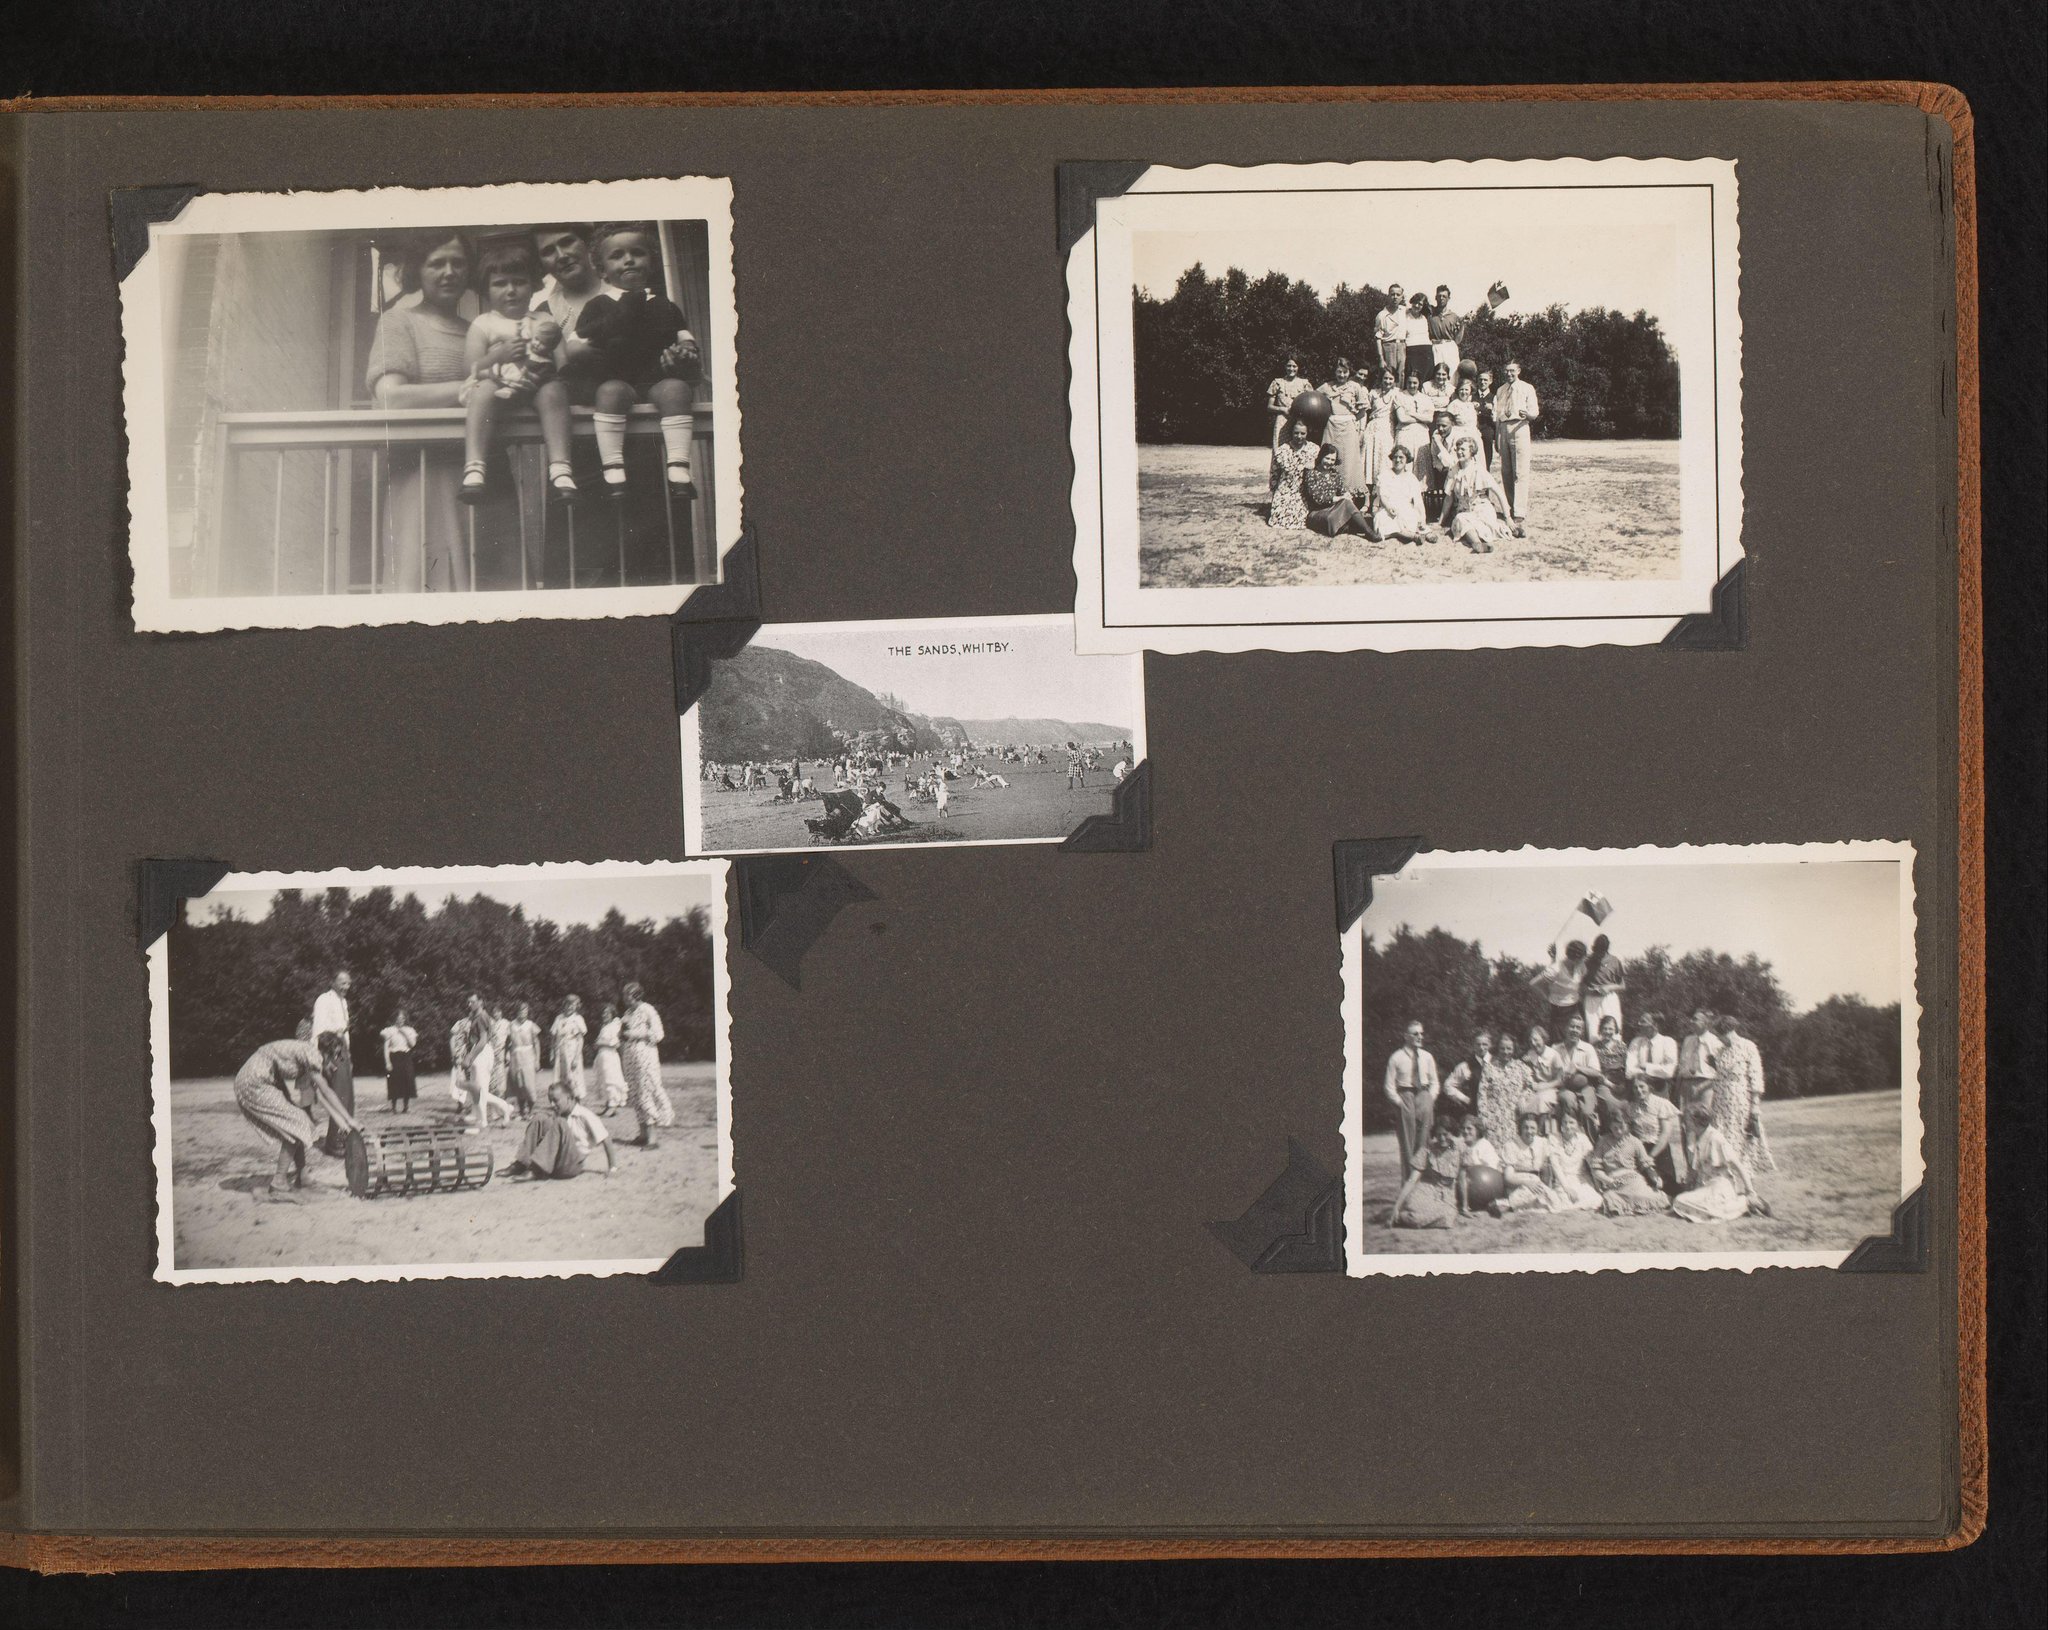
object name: album leaf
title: Esperanto zomerkamp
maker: Anonymous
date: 1908-1934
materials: paper, photographic support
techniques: gelatin silver print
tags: esperanto, open-air recreation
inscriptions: inscription: ‘5-8-'34’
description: Albumblad met vier foto's van een groep mensen op een Esperanto bijeenkomst, zomerfeest of zomerkamp, augustus 1934, en van twee vrouwen met kinderen op een balkon en een afbeelding van The Sands in Whitby. Onderdeel van het Esperanto album uit ca. 1933-1936.